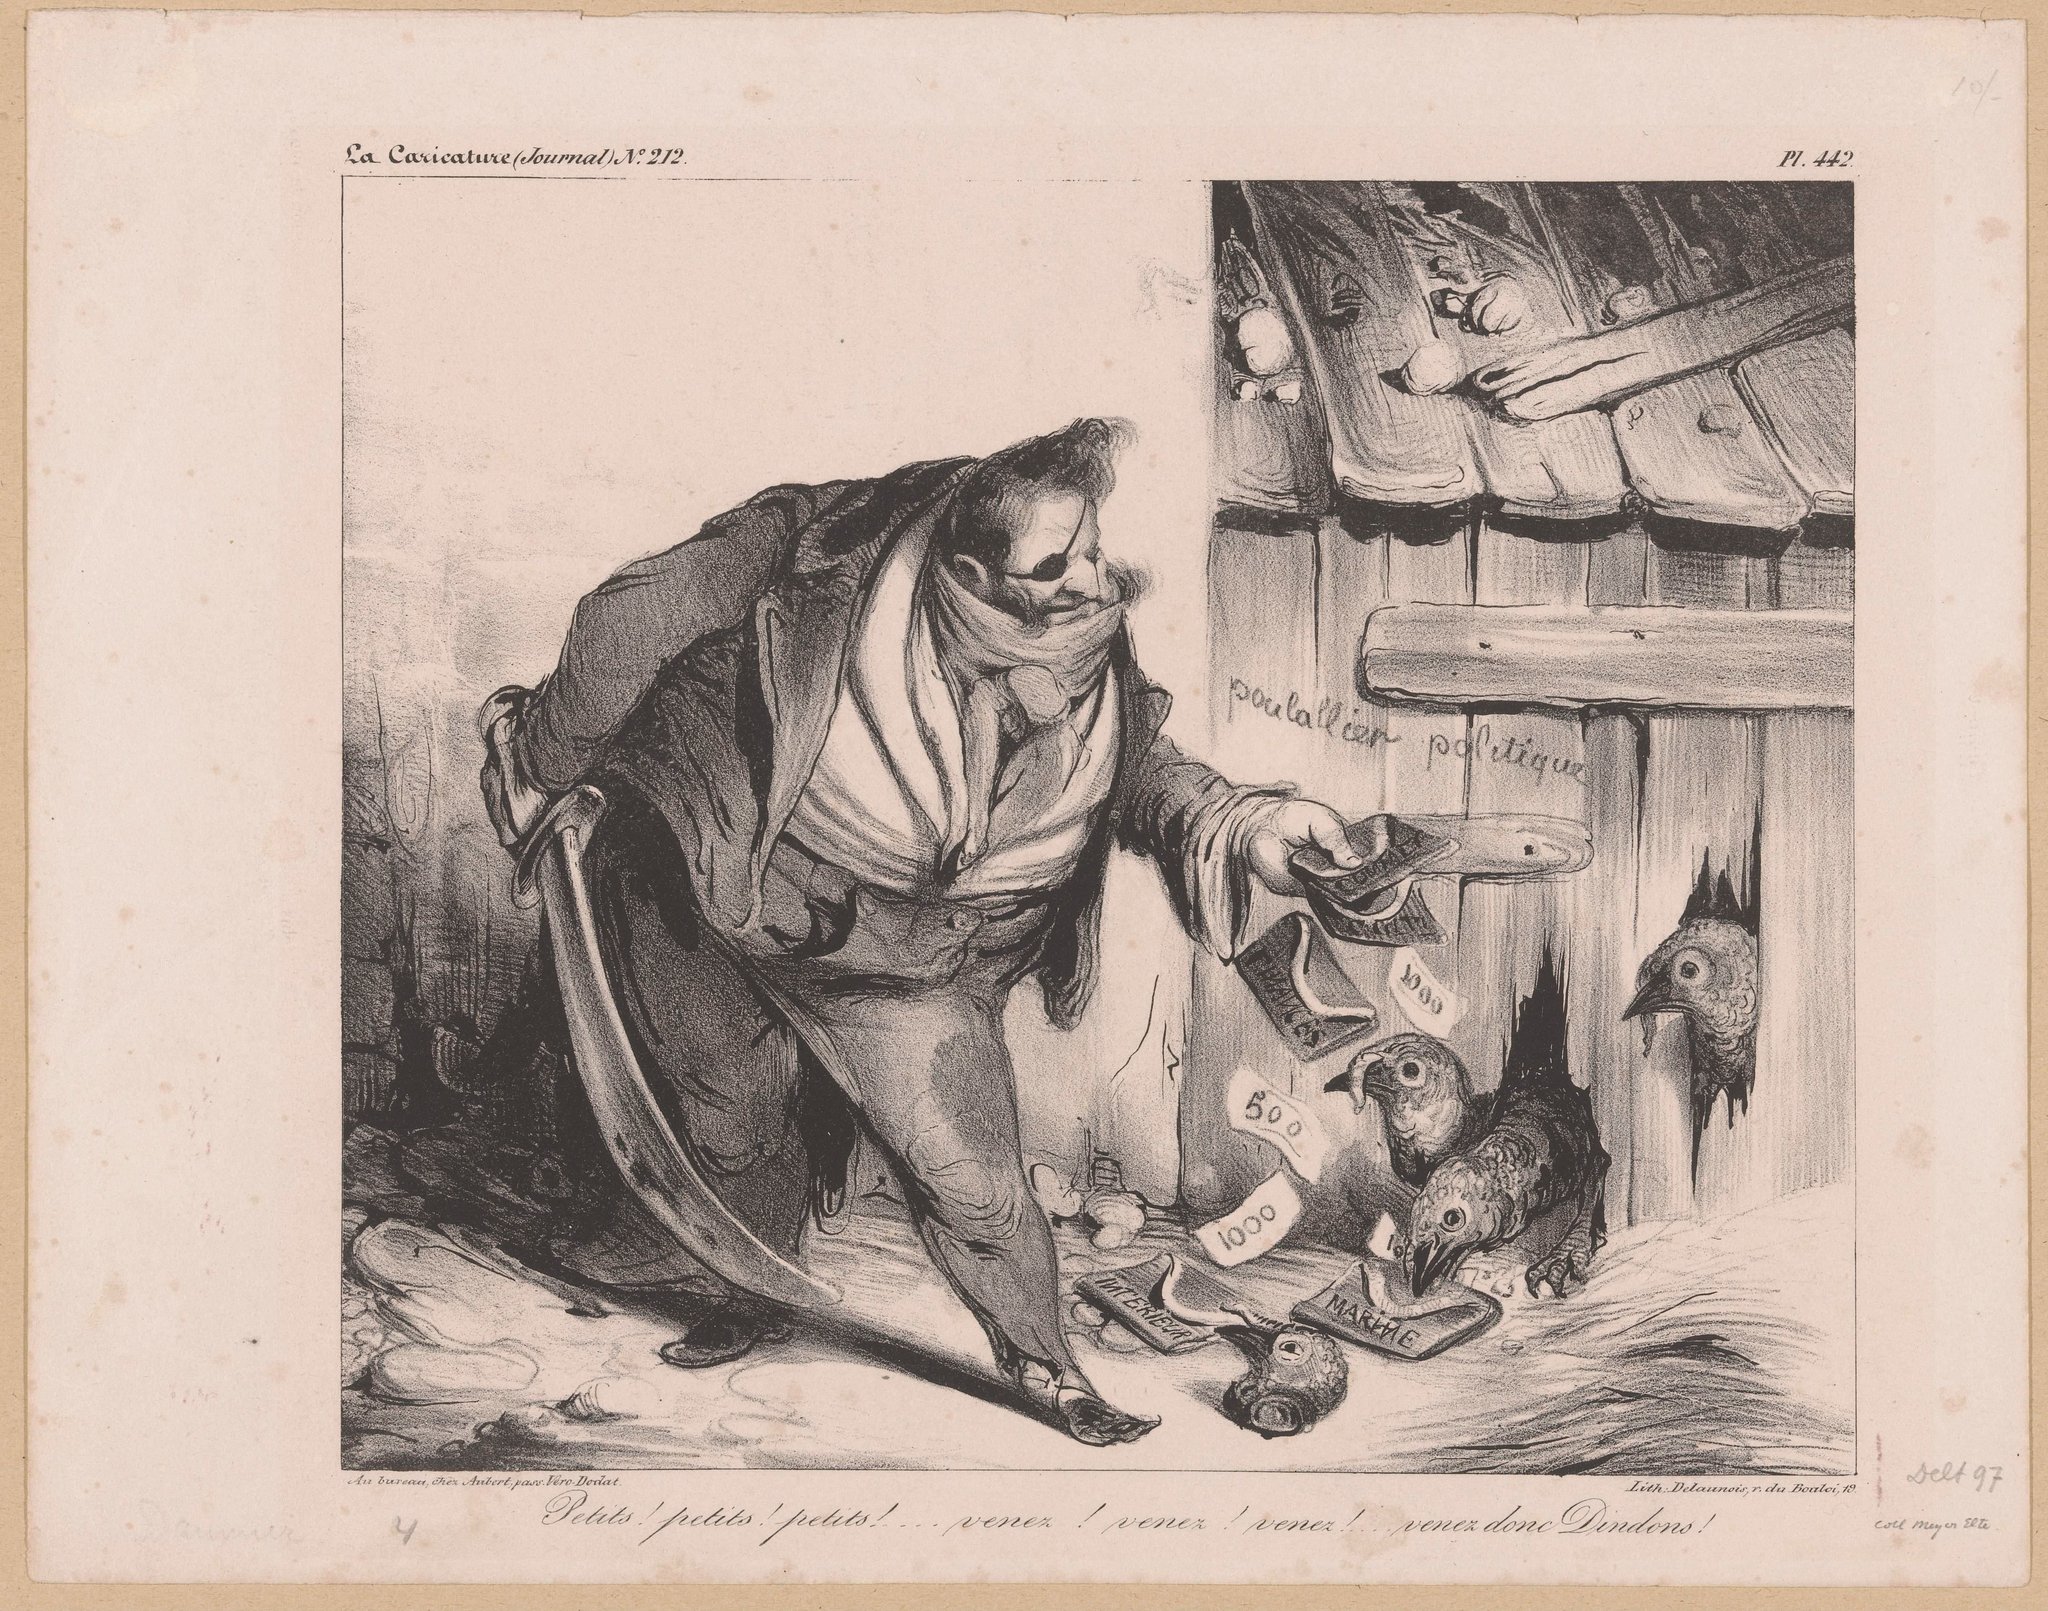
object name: print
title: Karikatuur van koning Lodewijk Filips I van Frankrijk als bandiet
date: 1835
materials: paper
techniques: lithograph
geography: paris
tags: paris, lodewijk filips i (koning van frankrijk), caricatures (human types), robber, poultry house, political caricatures and satires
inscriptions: collector's mark: Lugt 2228a, annotation: ‘coll Meyer Elte’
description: Koning Lodewijk Filips I van Frankrijk is afgebeeld als Robert Macaire, een fictief personage dat optreedt als een gewetenloze oplichter. Hij lokt de kalkoenen het hok uit met bankbiljetten en portefeuilles, om ze vervolgens een kopje kleiner te maken.